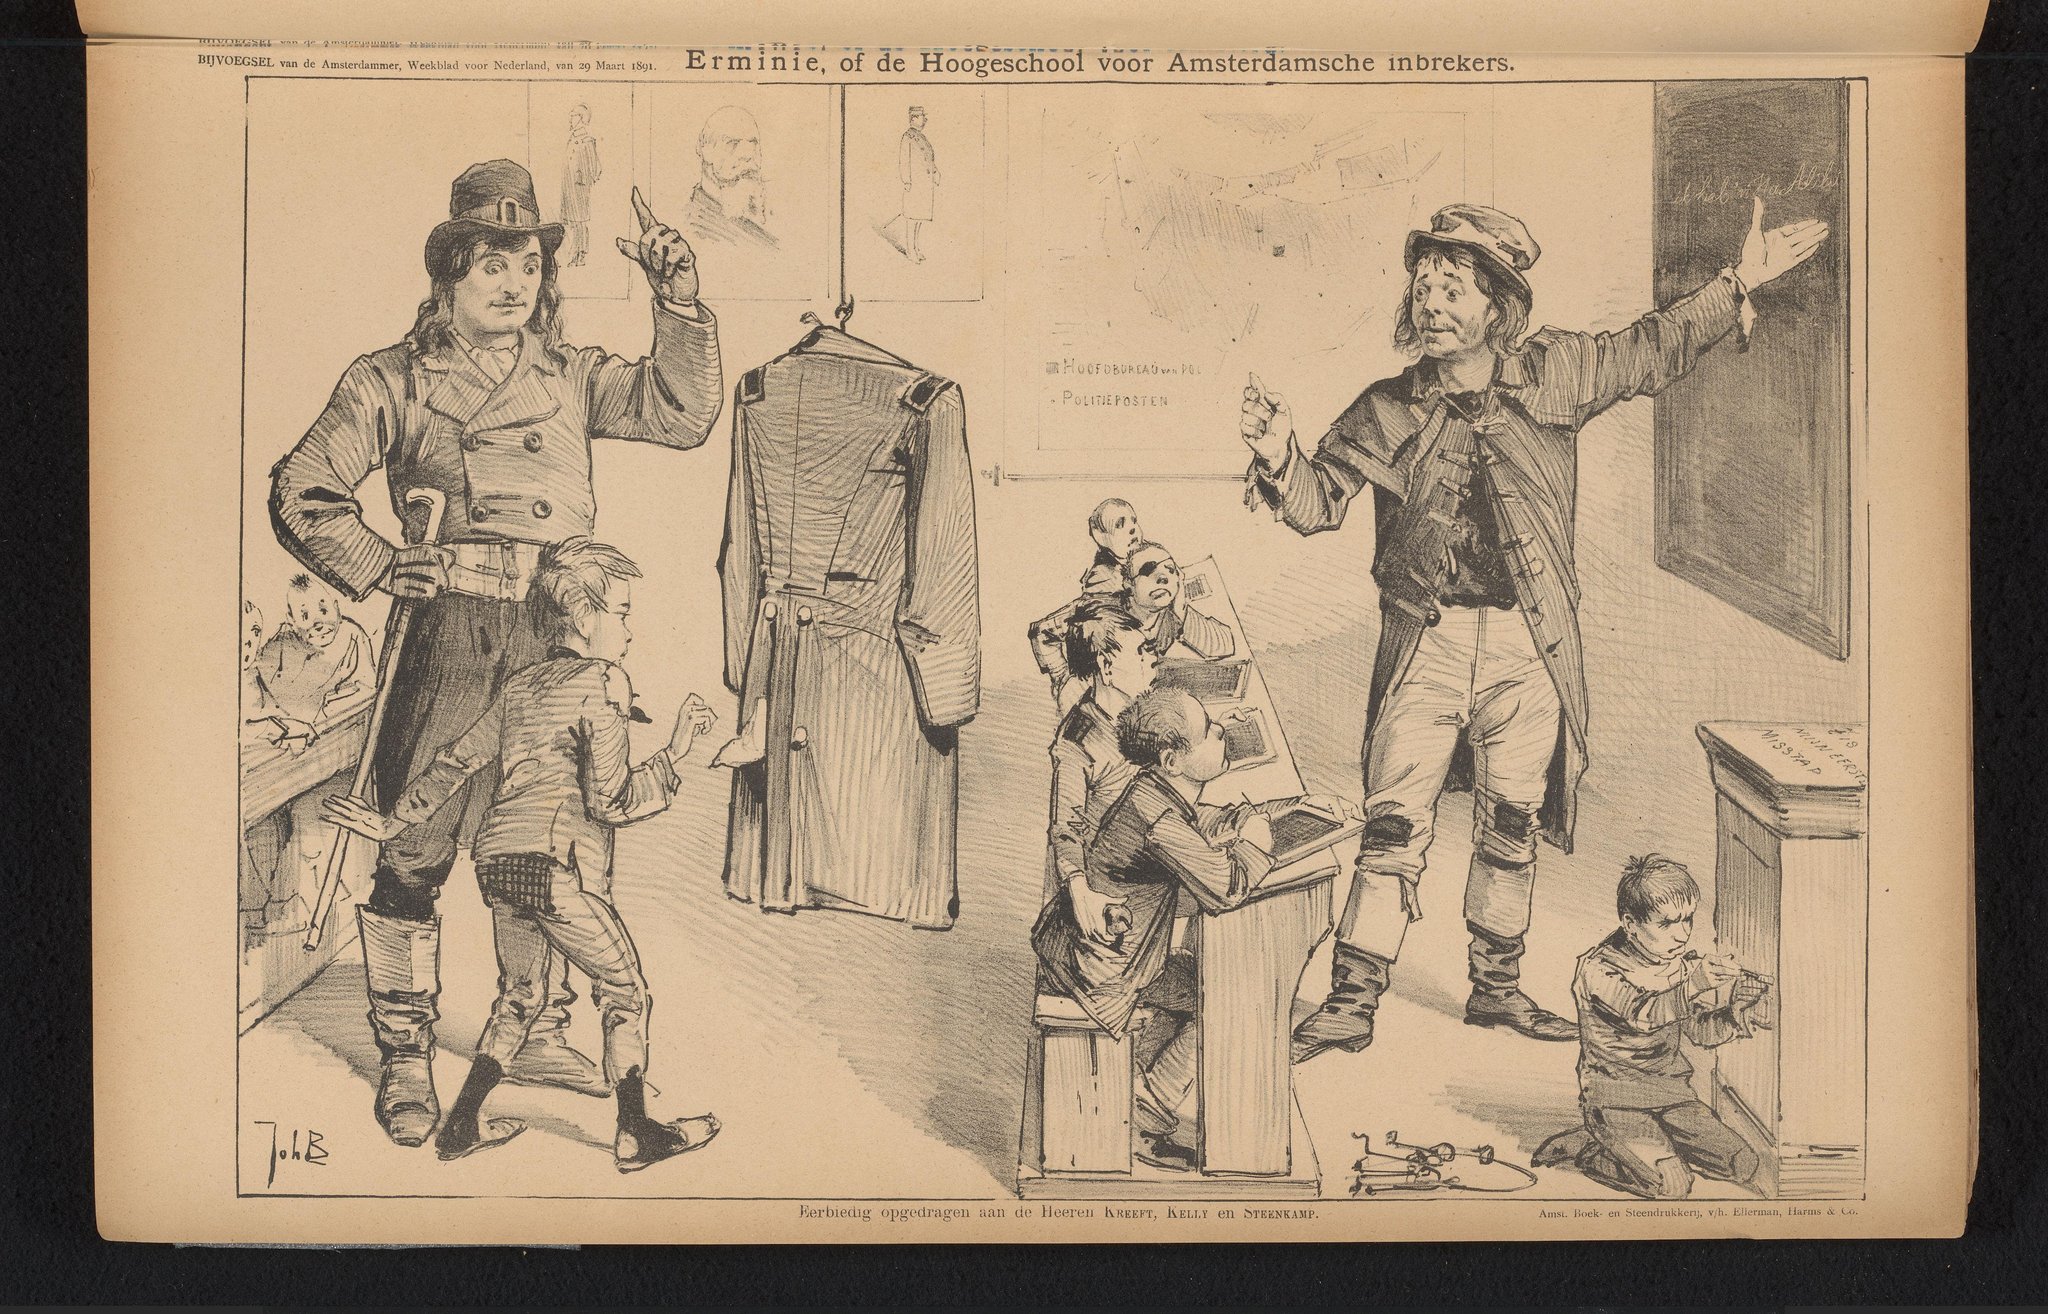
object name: cartoon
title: Erminie, of de Hoogeschool voor Amsterdamsche inbrekers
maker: johan braakensiek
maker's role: draughtsman, print maker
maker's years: 1858-1940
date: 1891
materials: paper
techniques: lithograph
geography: netherlands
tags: pickpocket, elementary school; class, form, political caricatures and satires, burglary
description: Amsterdamse schoollokaal waar jongens les krijgen in inbreken, zakkenrollen en bankkluis kraken.